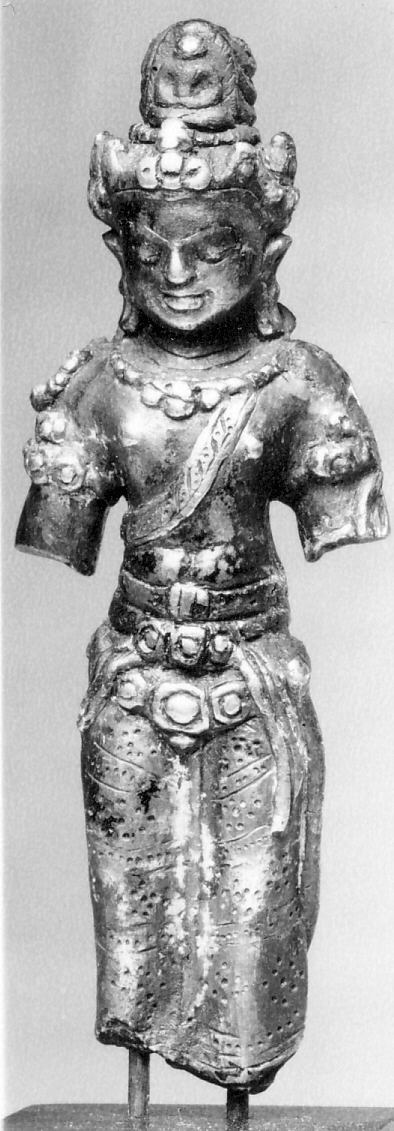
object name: figure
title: Standing Bodhisattva (Armless)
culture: indonesian, javanese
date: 801-900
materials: silver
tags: buddhism,bodhisattvas